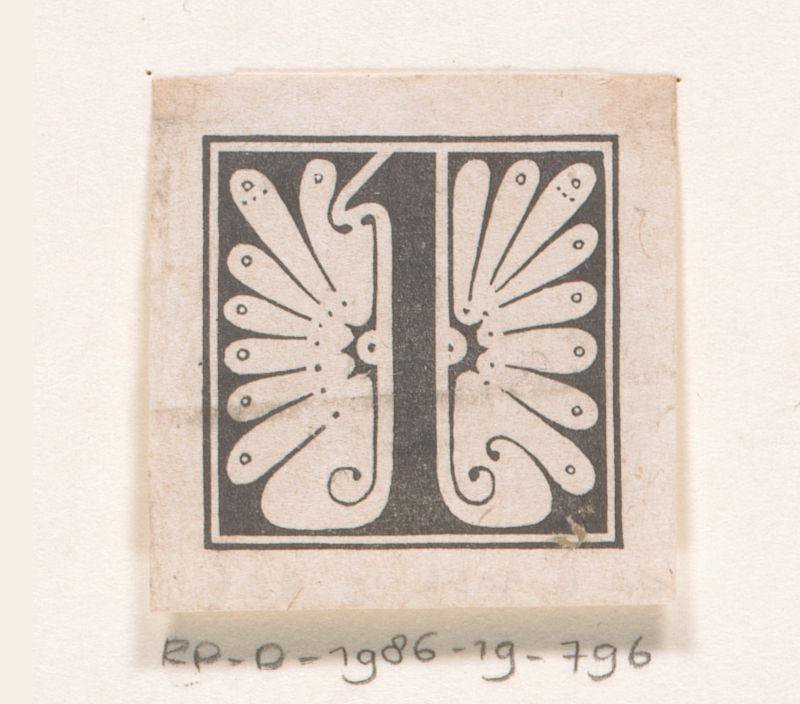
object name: photomechanical print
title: Getal 1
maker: reinier willem petrus de vries (1874-1953)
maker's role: draughtsman, print maker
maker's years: 1874-1953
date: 1904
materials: paper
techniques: printing block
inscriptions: collector's mark: ‘R:MVS.’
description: Het getal is gebruikt voor: Veth, Jan. Jozef Israëls en zijn kunst. Arnhem en Nijmegen: Gebroeders E&M Cohen, 1904.